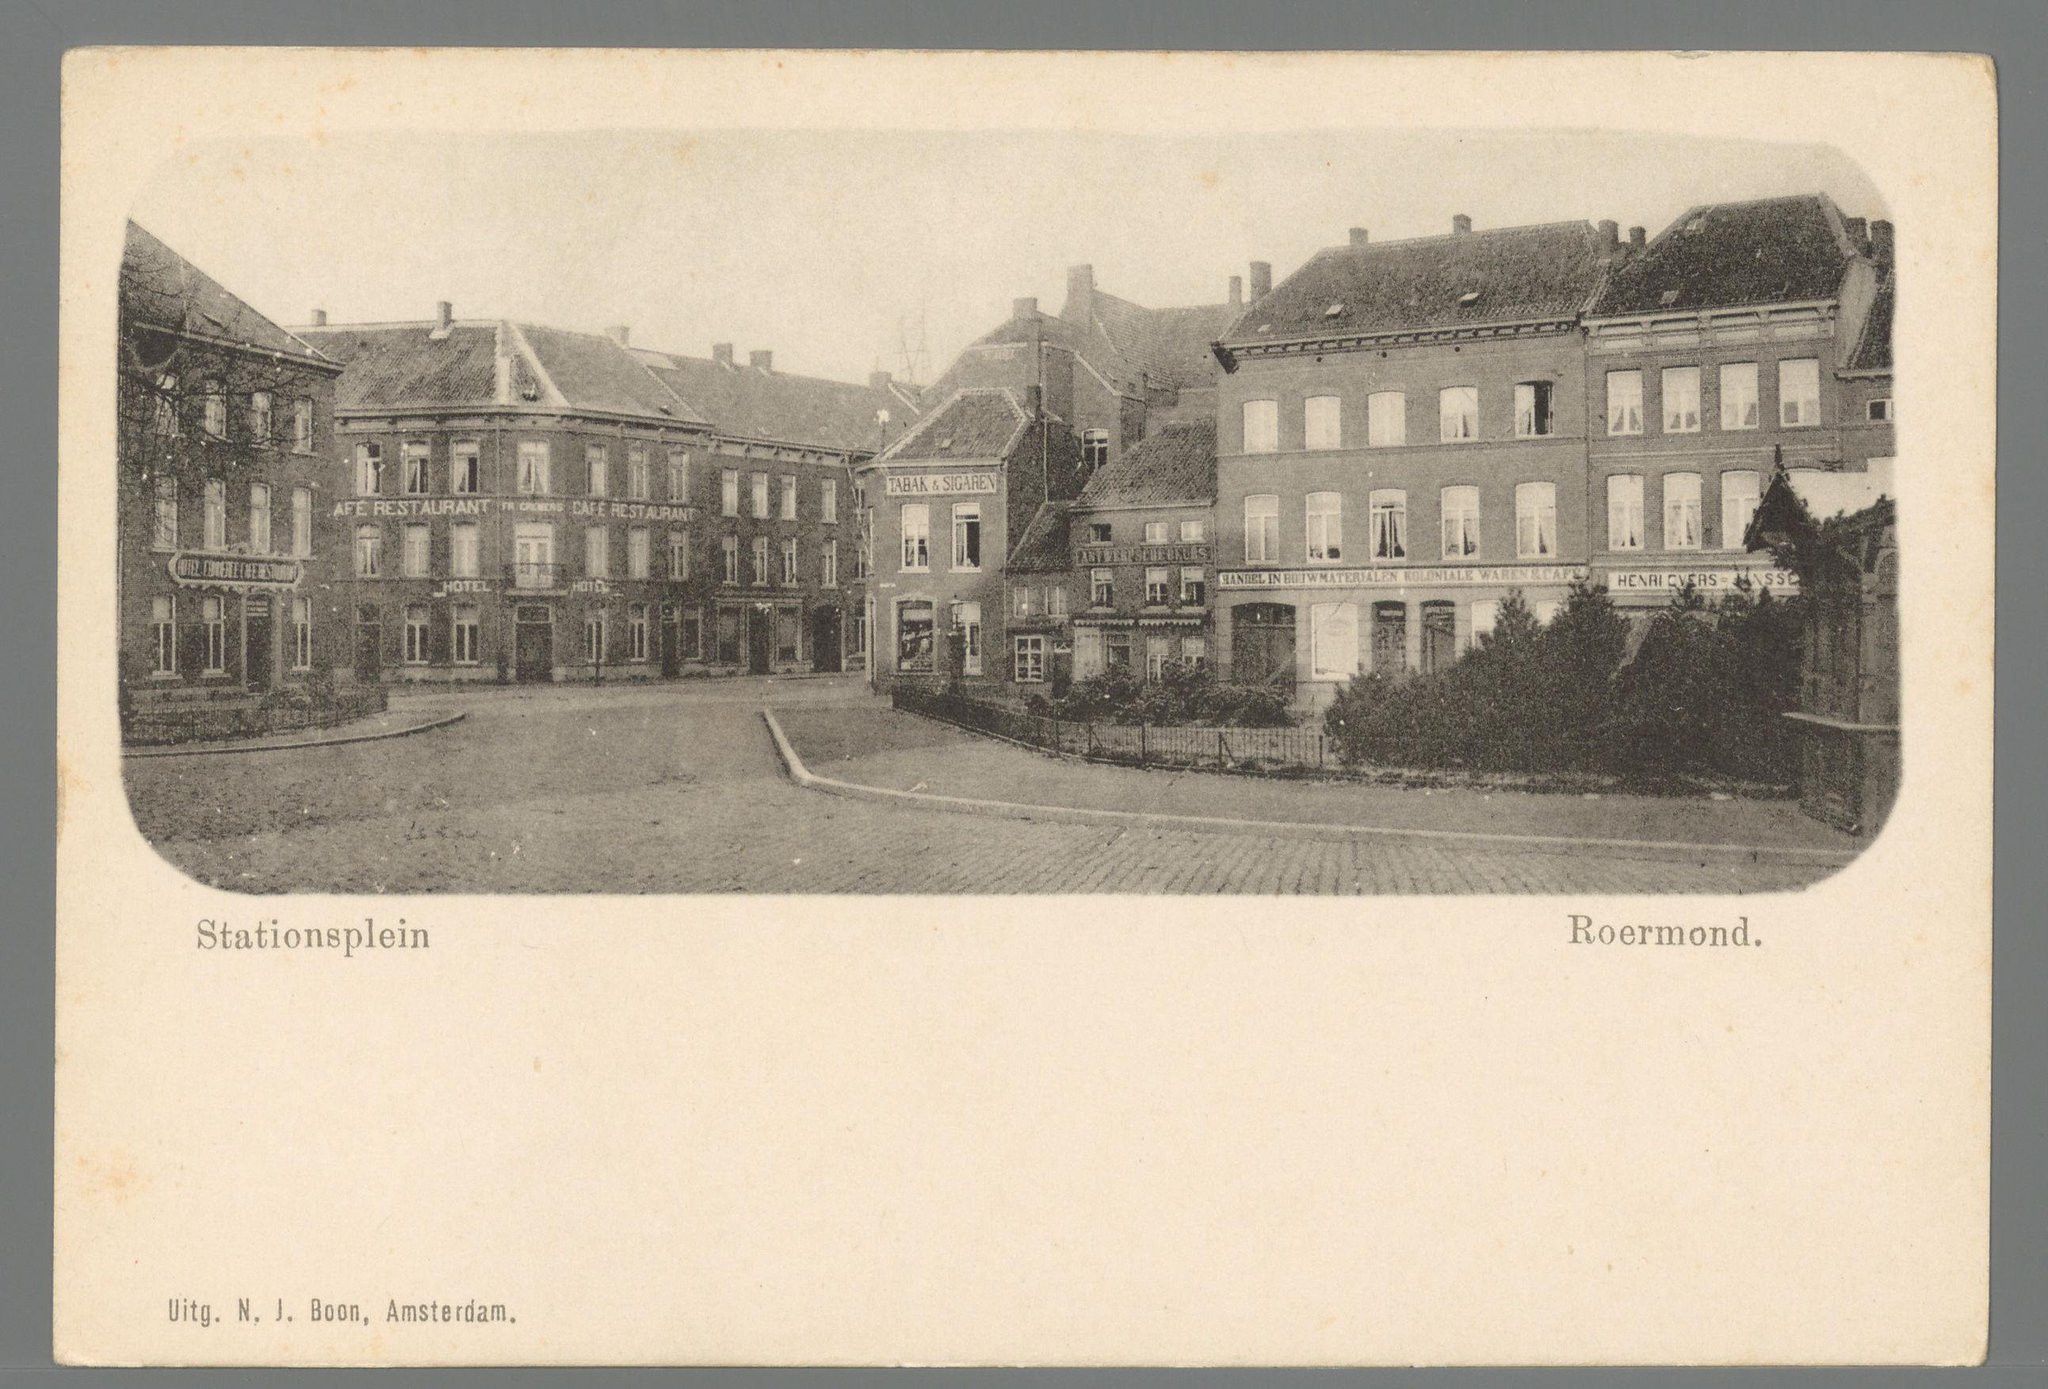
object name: photomechanical print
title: Stationsplein. Roermond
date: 1895-1901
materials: cardboard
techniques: photograph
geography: amsterdam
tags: square, place, circus, etc.